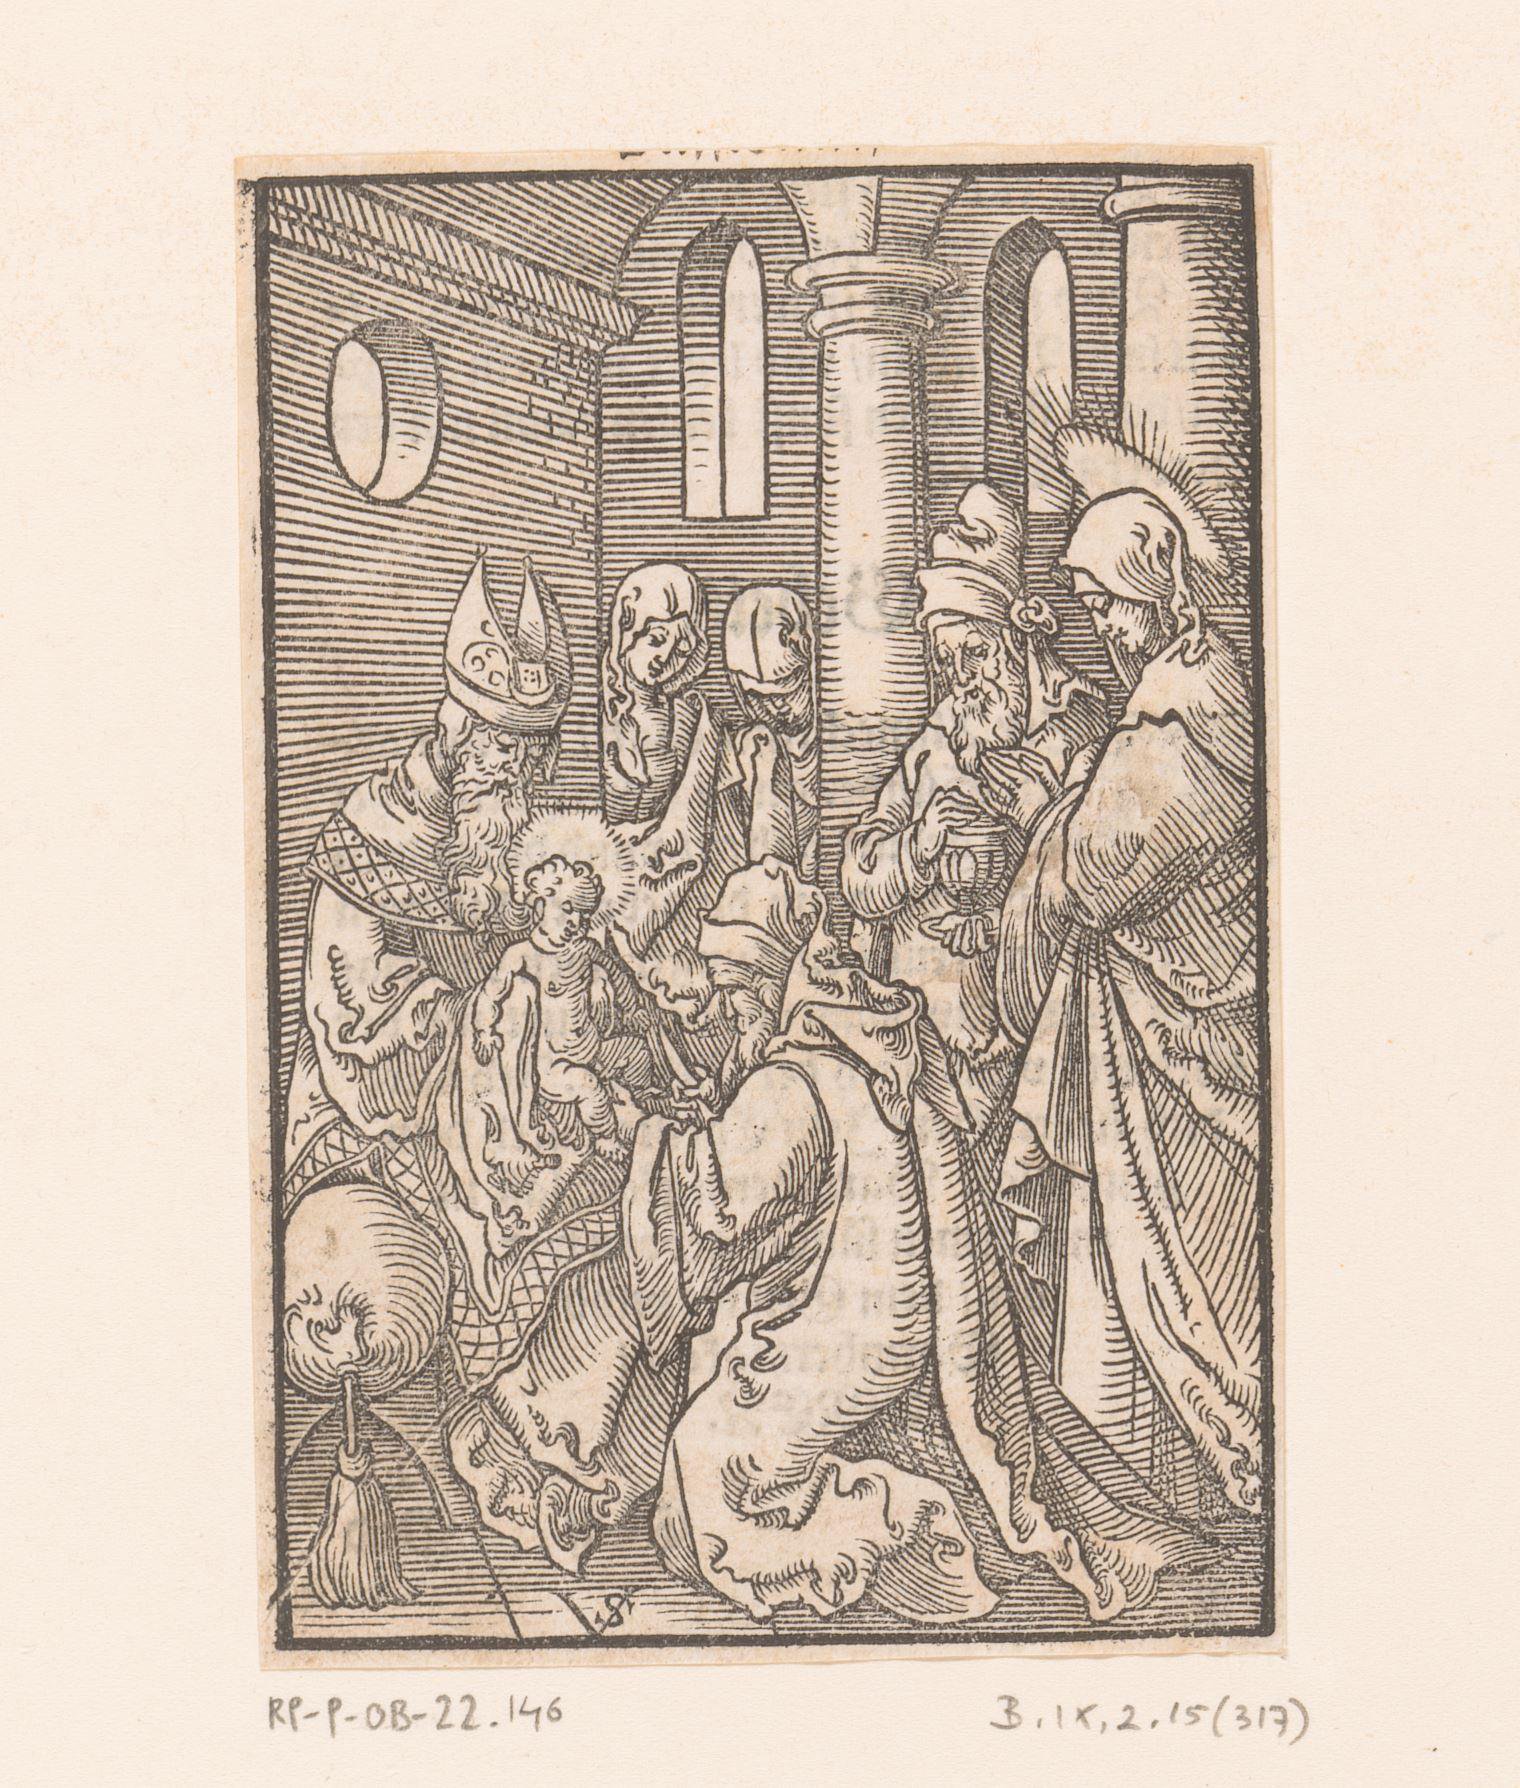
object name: print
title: Besnijdenis van Christus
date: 1552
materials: paper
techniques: woodcut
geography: nuremberg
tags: circumcision of the christ-child by the priest in the temple (luke 2:21)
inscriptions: number: ‘181’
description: Gebruikt voor verschillende publicaties die werden gedrukt door Valentin Geißler tussen 1552 en 1560 te Neurenberg.